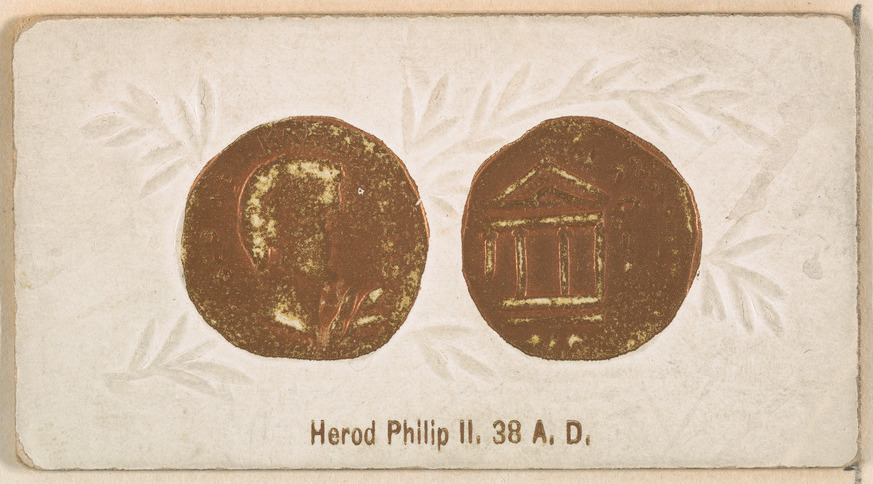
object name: print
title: Herod Philip II, 38 A.D., from the Ancient Coins series (N180) issued by Wm. S. Kimball & Co.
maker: william s. kimball & company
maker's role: publisher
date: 1888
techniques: color lithograph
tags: coins